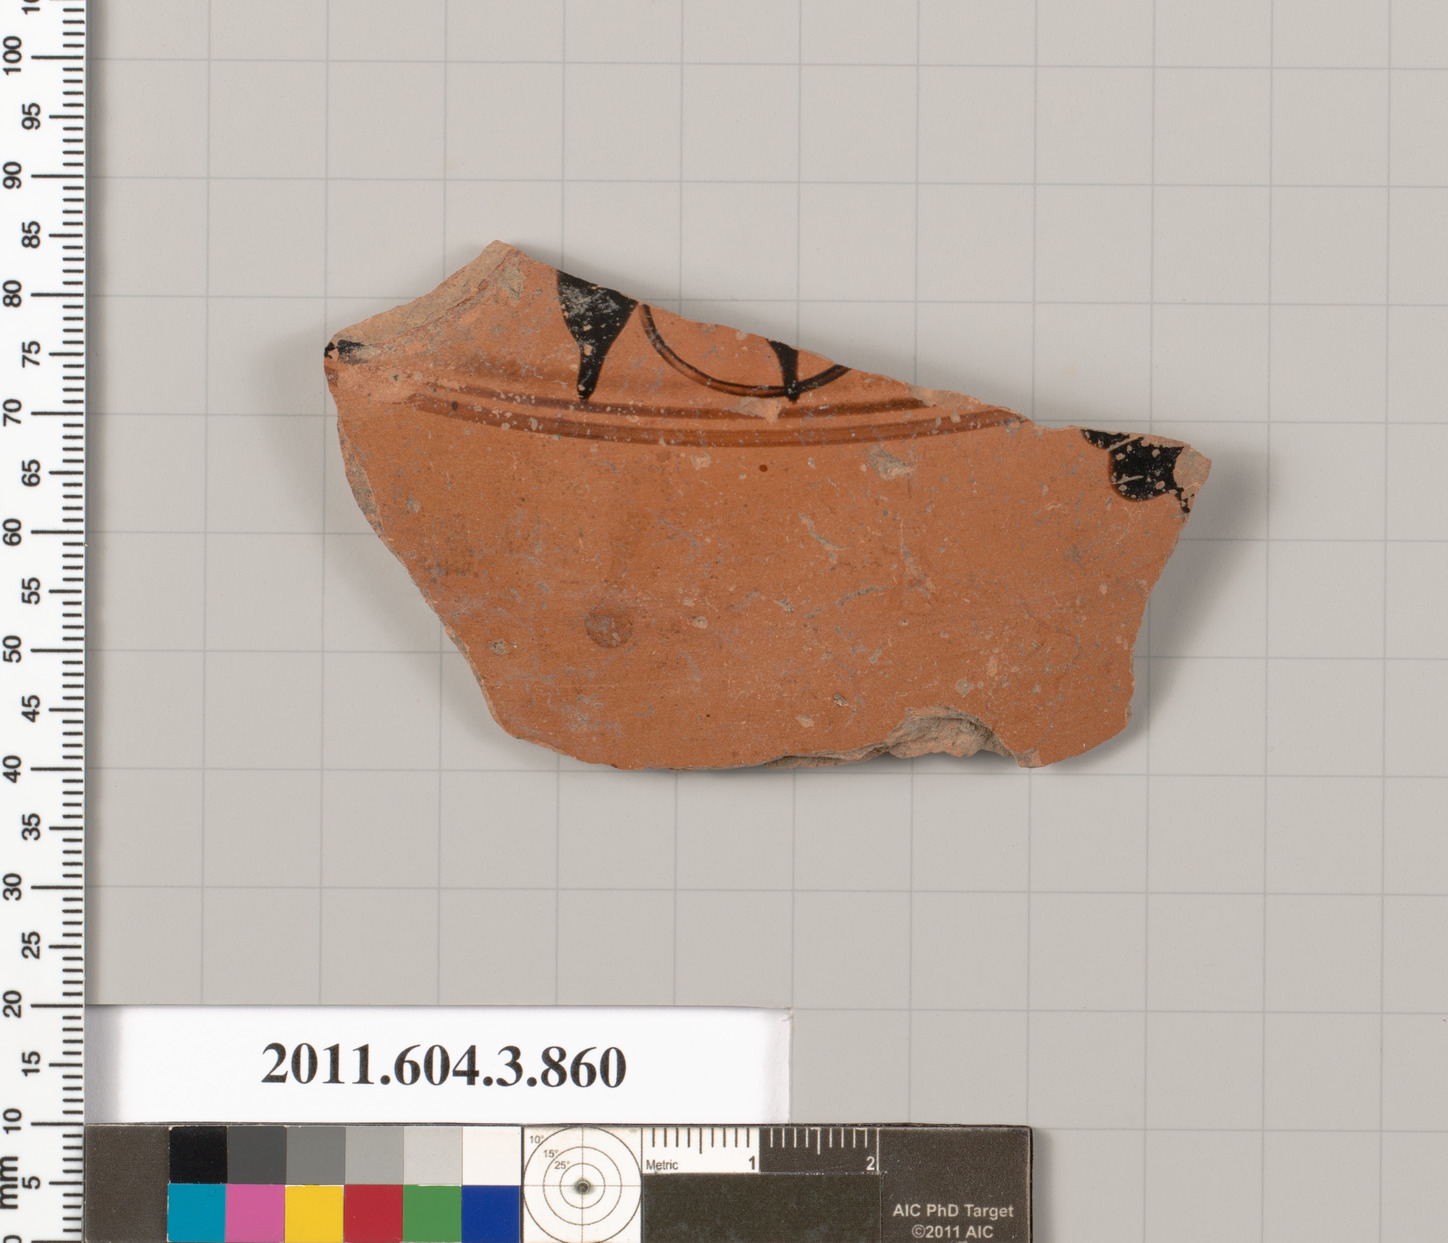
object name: lekythos fragment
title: Terracotta fragment of a lekythos (oil flask)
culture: greek, attic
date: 534-468 BCE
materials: terracotta